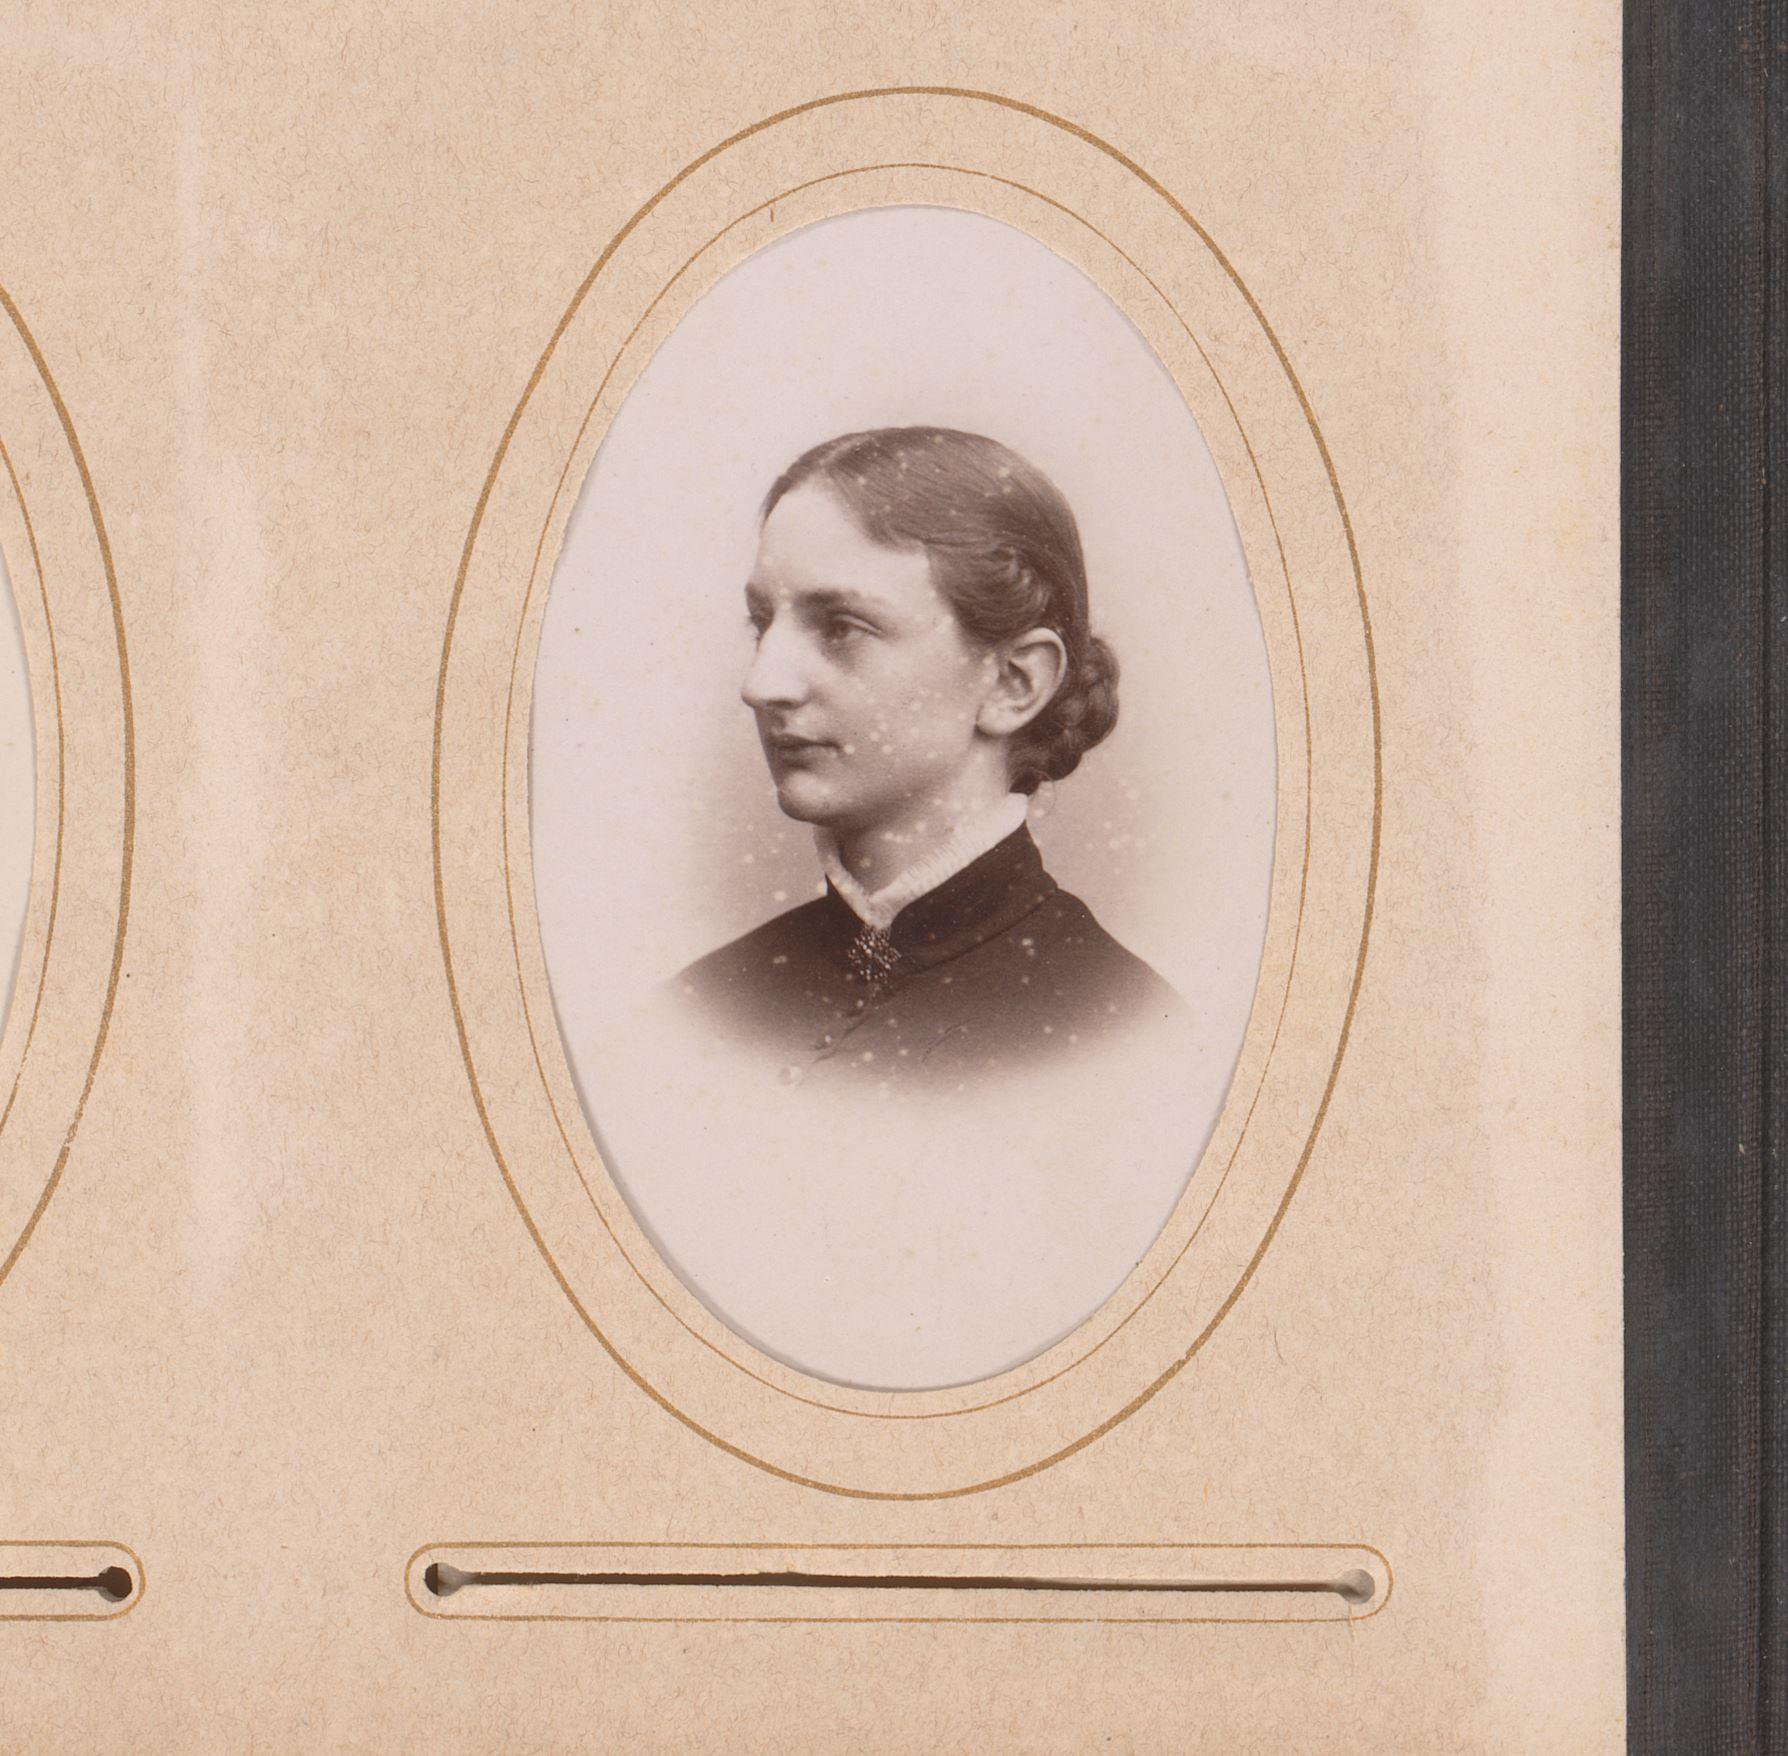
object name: carte de visite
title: Portret van een vrouw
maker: arnold nelius marinus johannes fock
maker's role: fotograaf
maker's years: 1846-1901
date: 1867-1901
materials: cardboard, photographic support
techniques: albumen print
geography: utrecht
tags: historical persons - bb - woman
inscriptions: inscription: ‘A.N.M.J. FOck/ Photographie instantanée/ Utrecht’